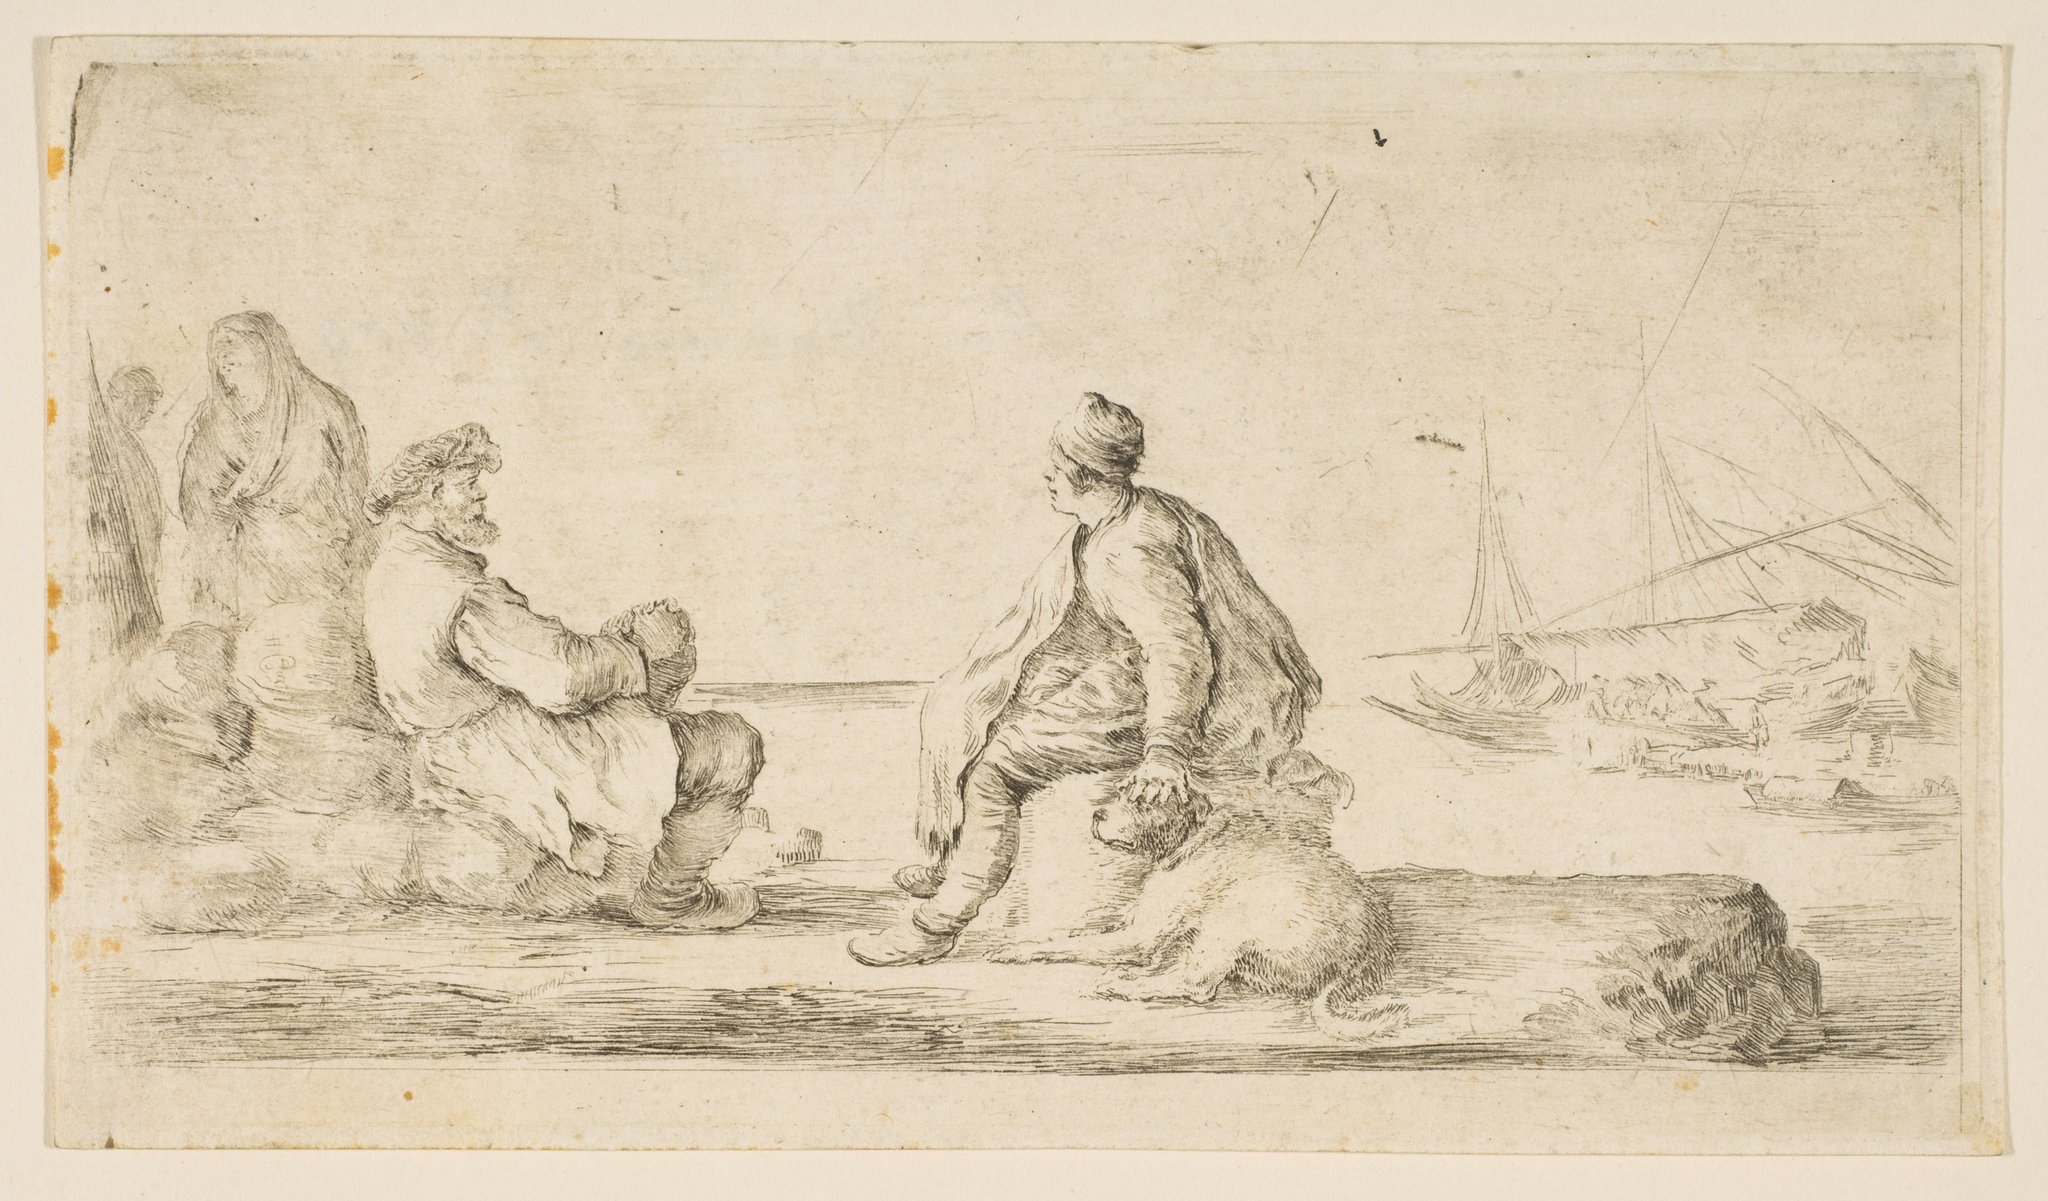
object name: print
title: A young sailor and an old man sitting by the sea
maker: stefano della bella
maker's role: artist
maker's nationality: italian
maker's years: 1610-1664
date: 1601-1700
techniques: etching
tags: men,dogs,sailors